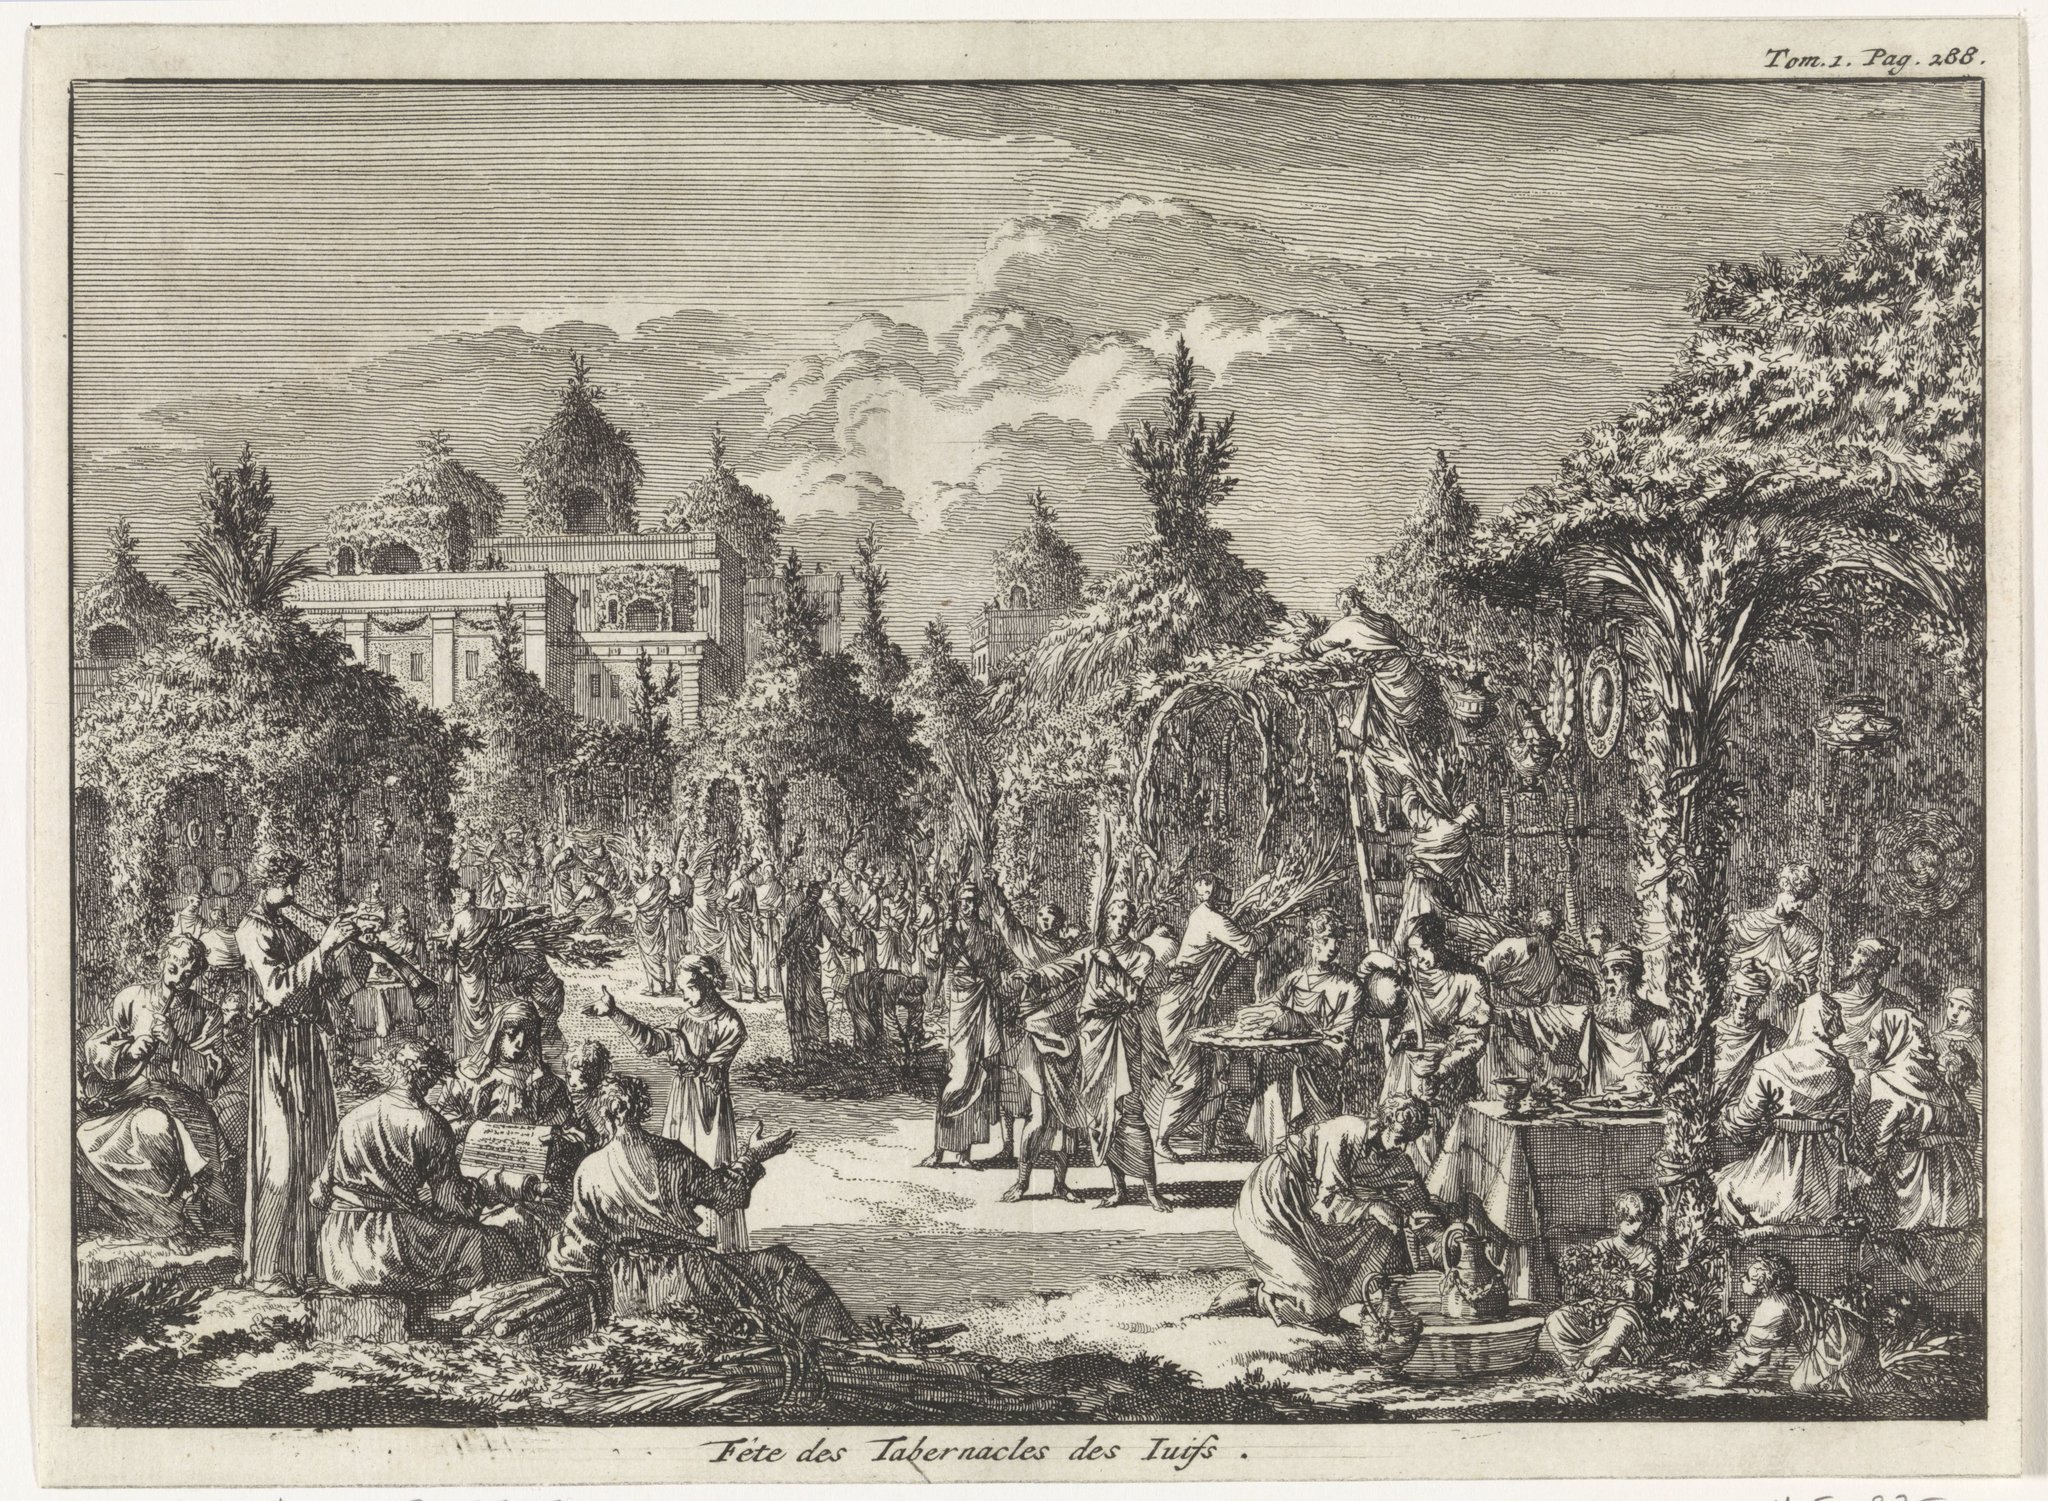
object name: print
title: Fête des Tabernacles des Juifs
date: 1705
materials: paper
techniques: etching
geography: amsterdam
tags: 'sukkot', feast of the tabernacles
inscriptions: collector's mark: Lugt 2228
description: Illustratie uit: Cunaeus, Petrus. La republique des Hebreux, 3 delen. Amsterdam: Pieter Mortier, 1705, dl. I, p. 288.